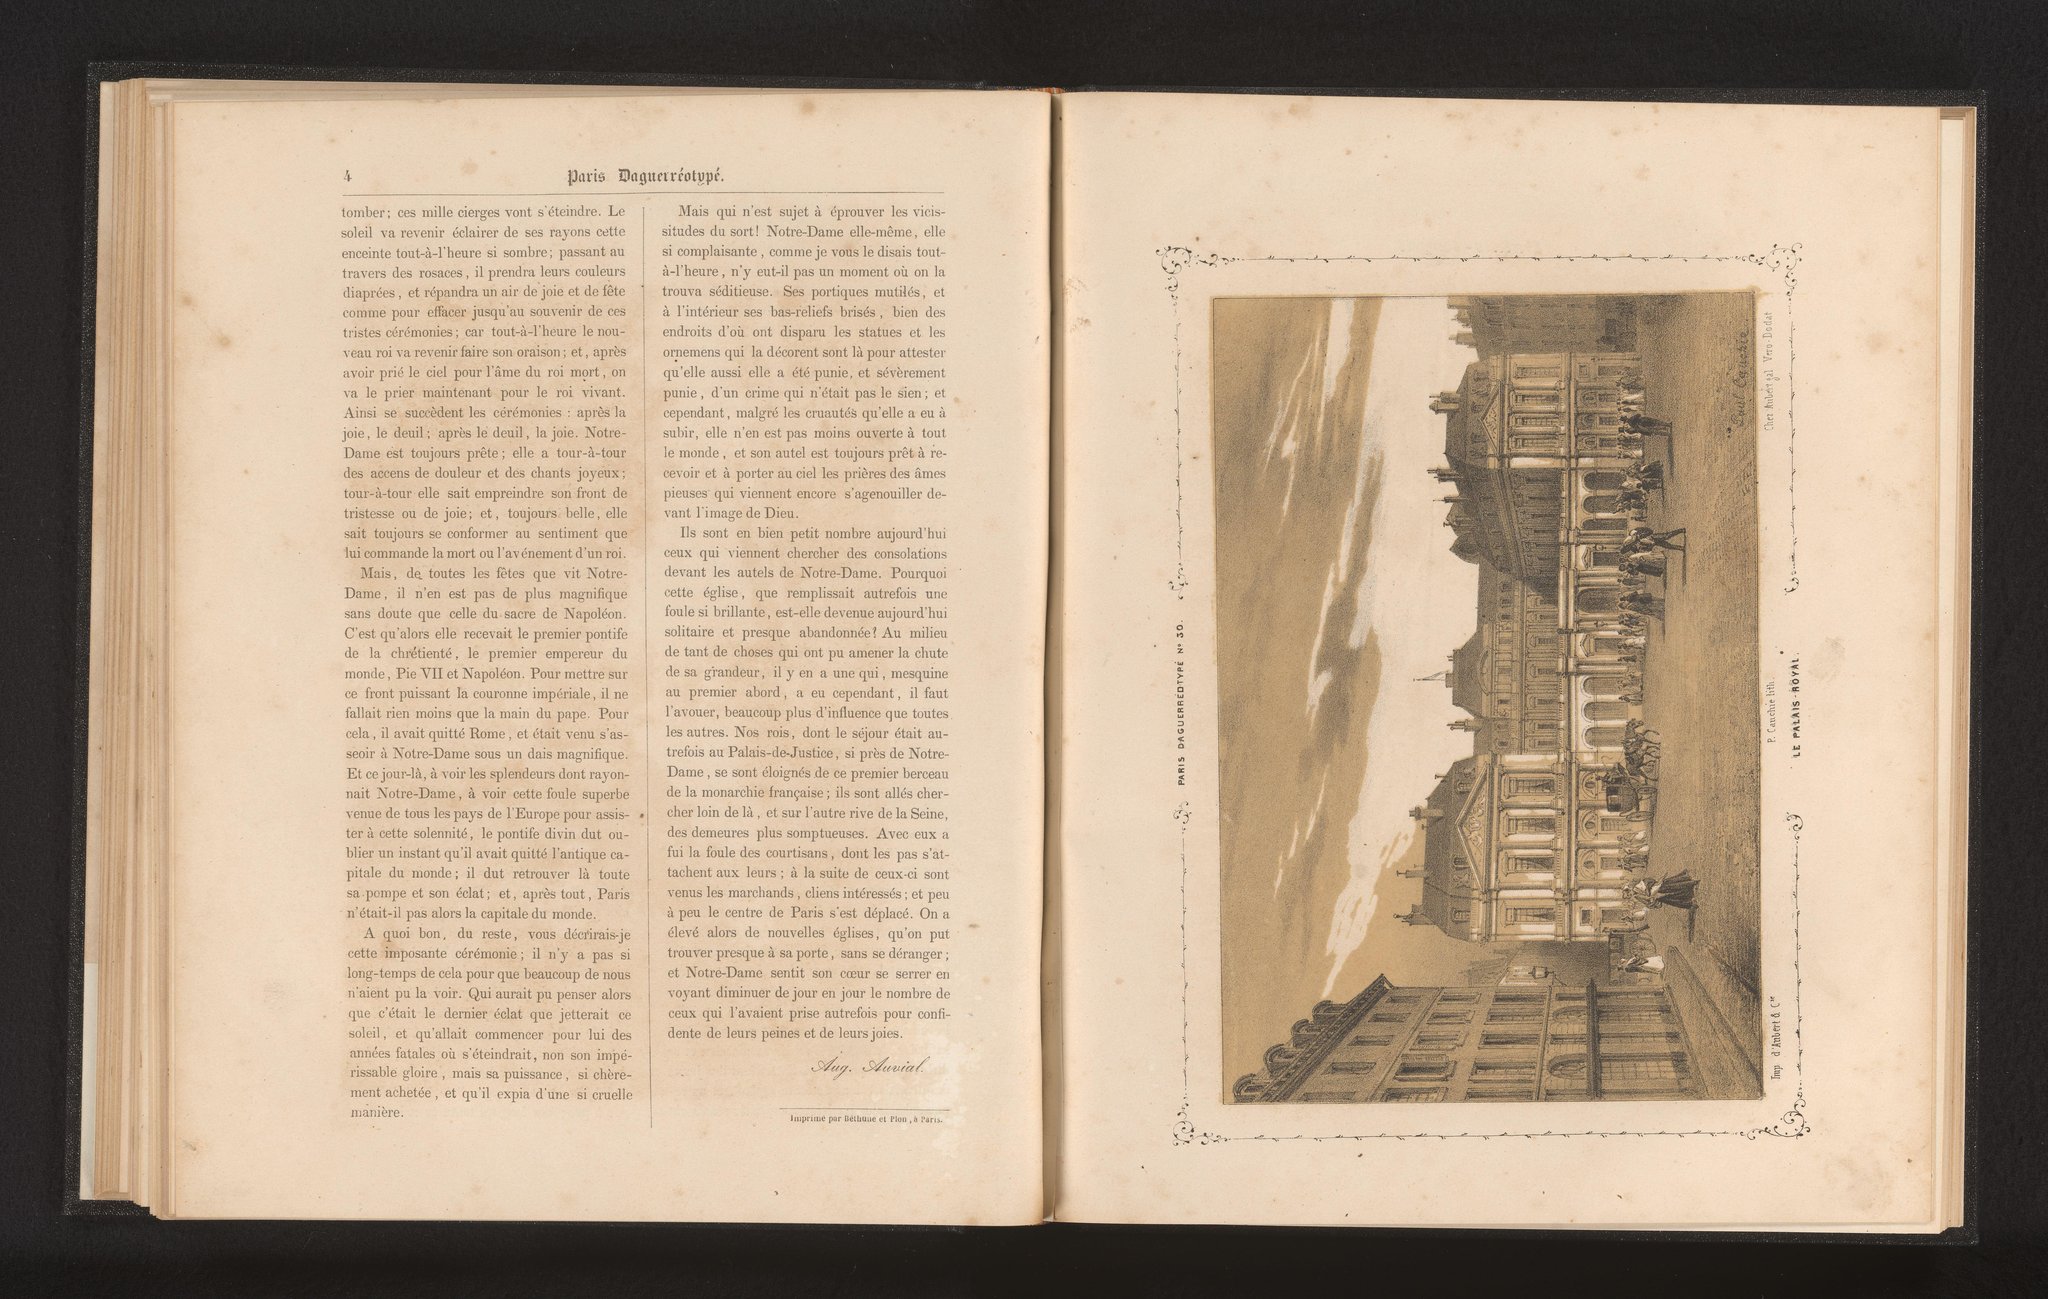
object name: page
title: Le Palais-Royal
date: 1839-1840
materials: paper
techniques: tone lithography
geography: paris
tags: palace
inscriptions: inscription: ‘PARIS DAGUERRÉOTYPÉ No. 30.’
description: Prent op honderdnegentiende ongenummerde pagina.